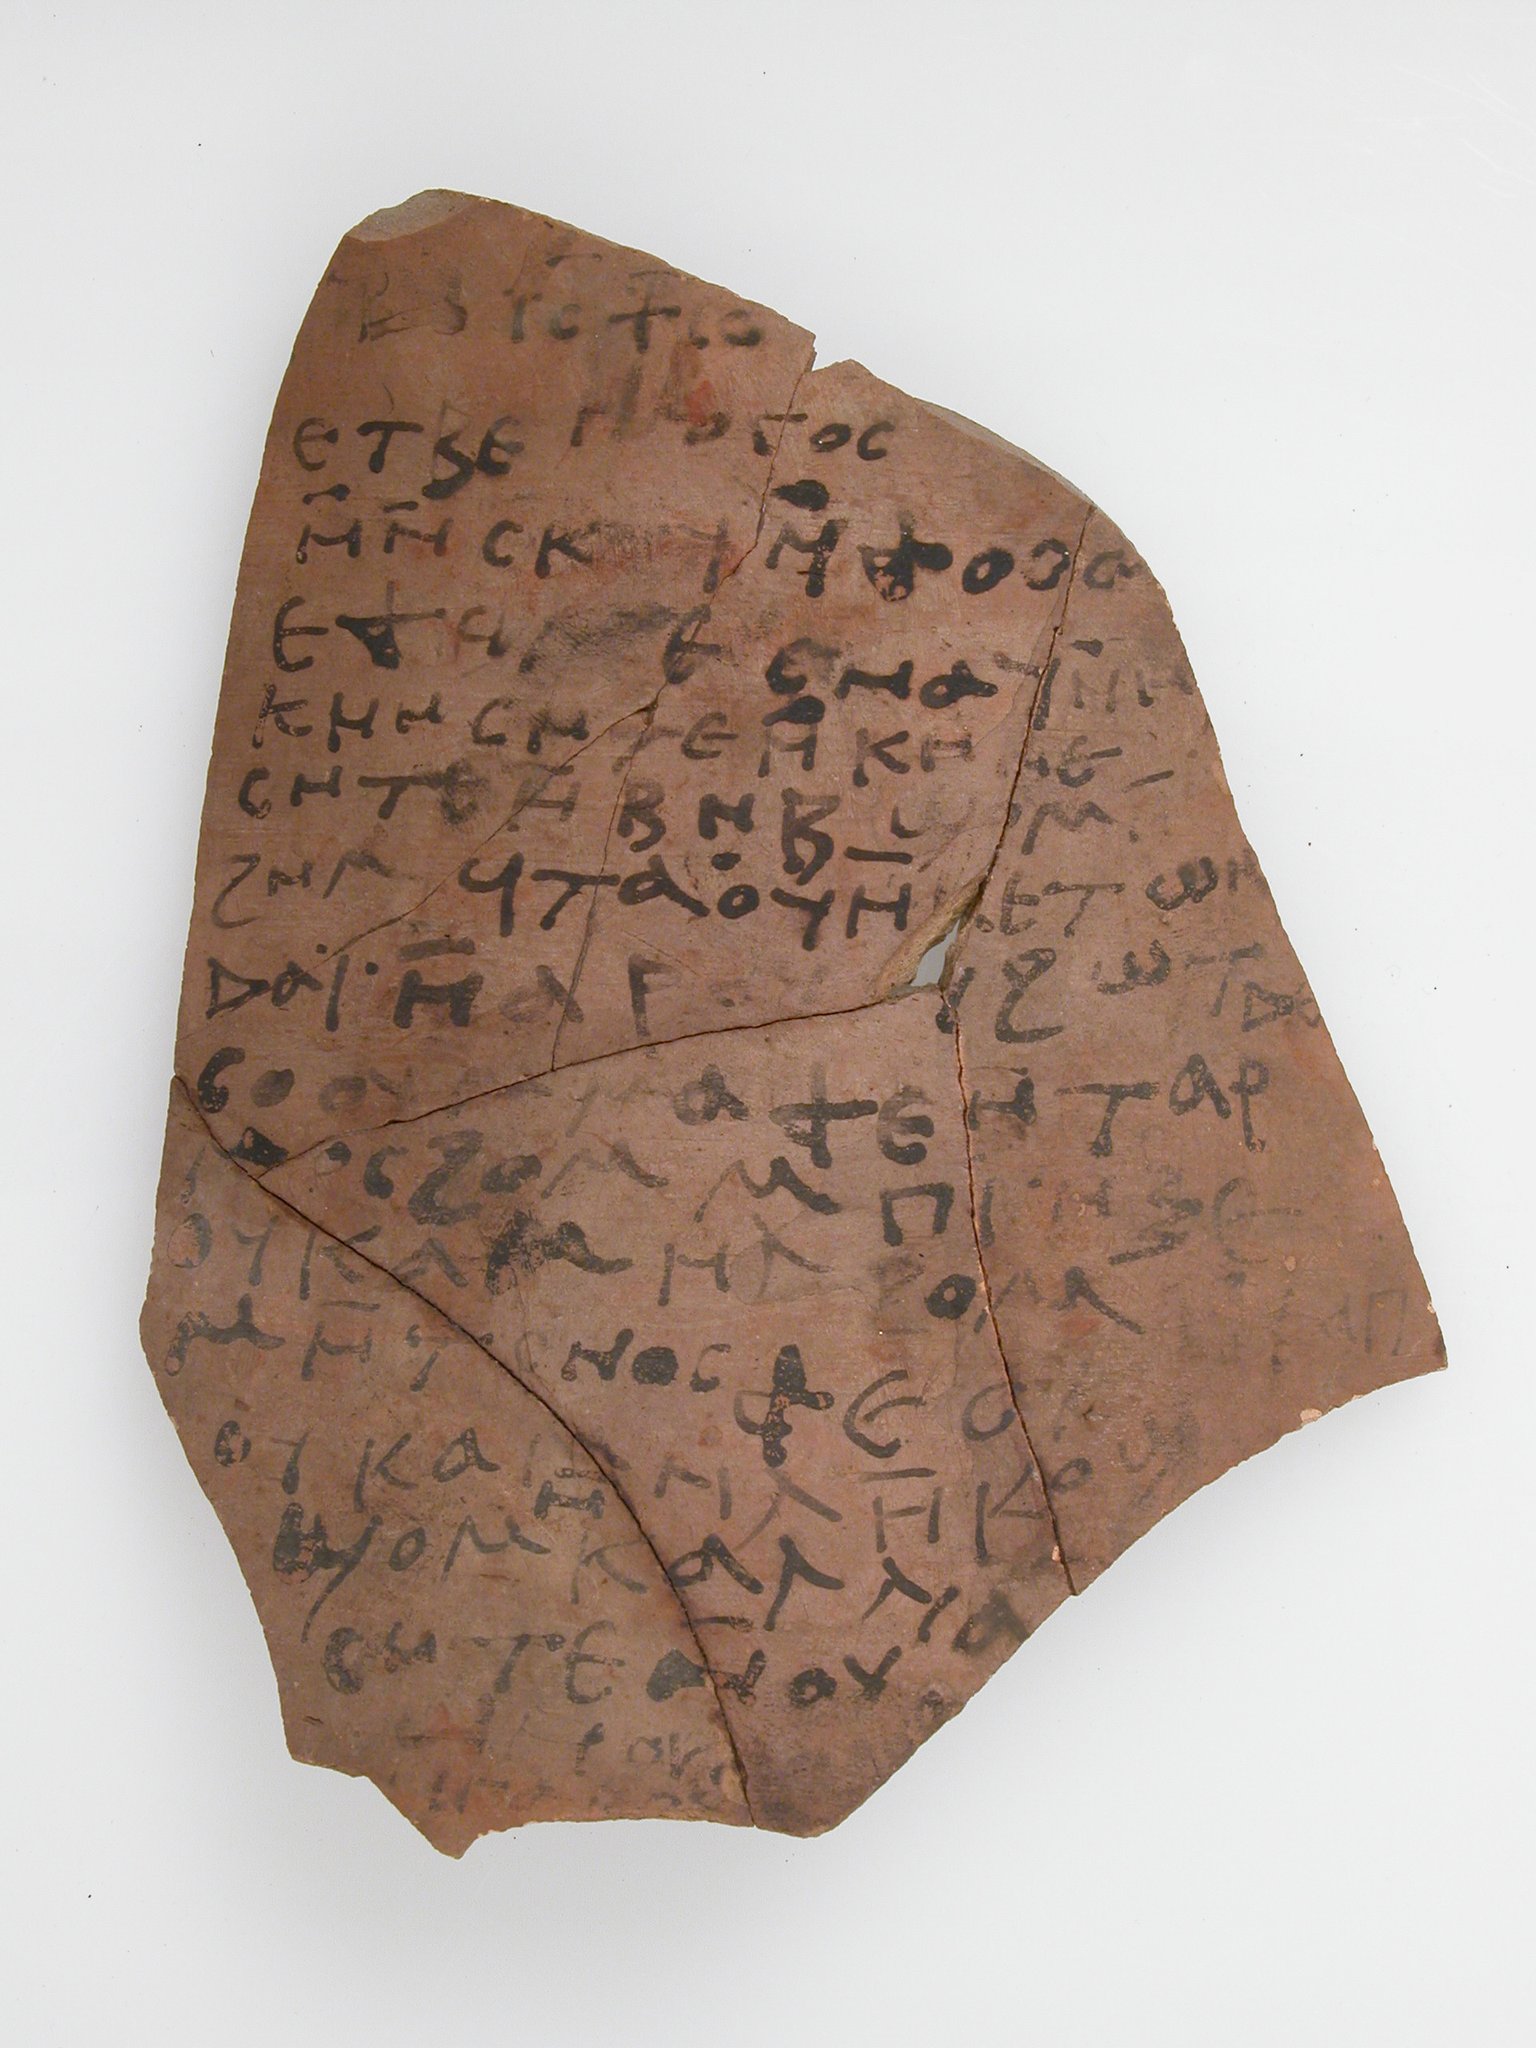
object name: ostrakon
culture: coptic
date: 601-700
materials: ink, pottery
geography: egypt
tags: documents